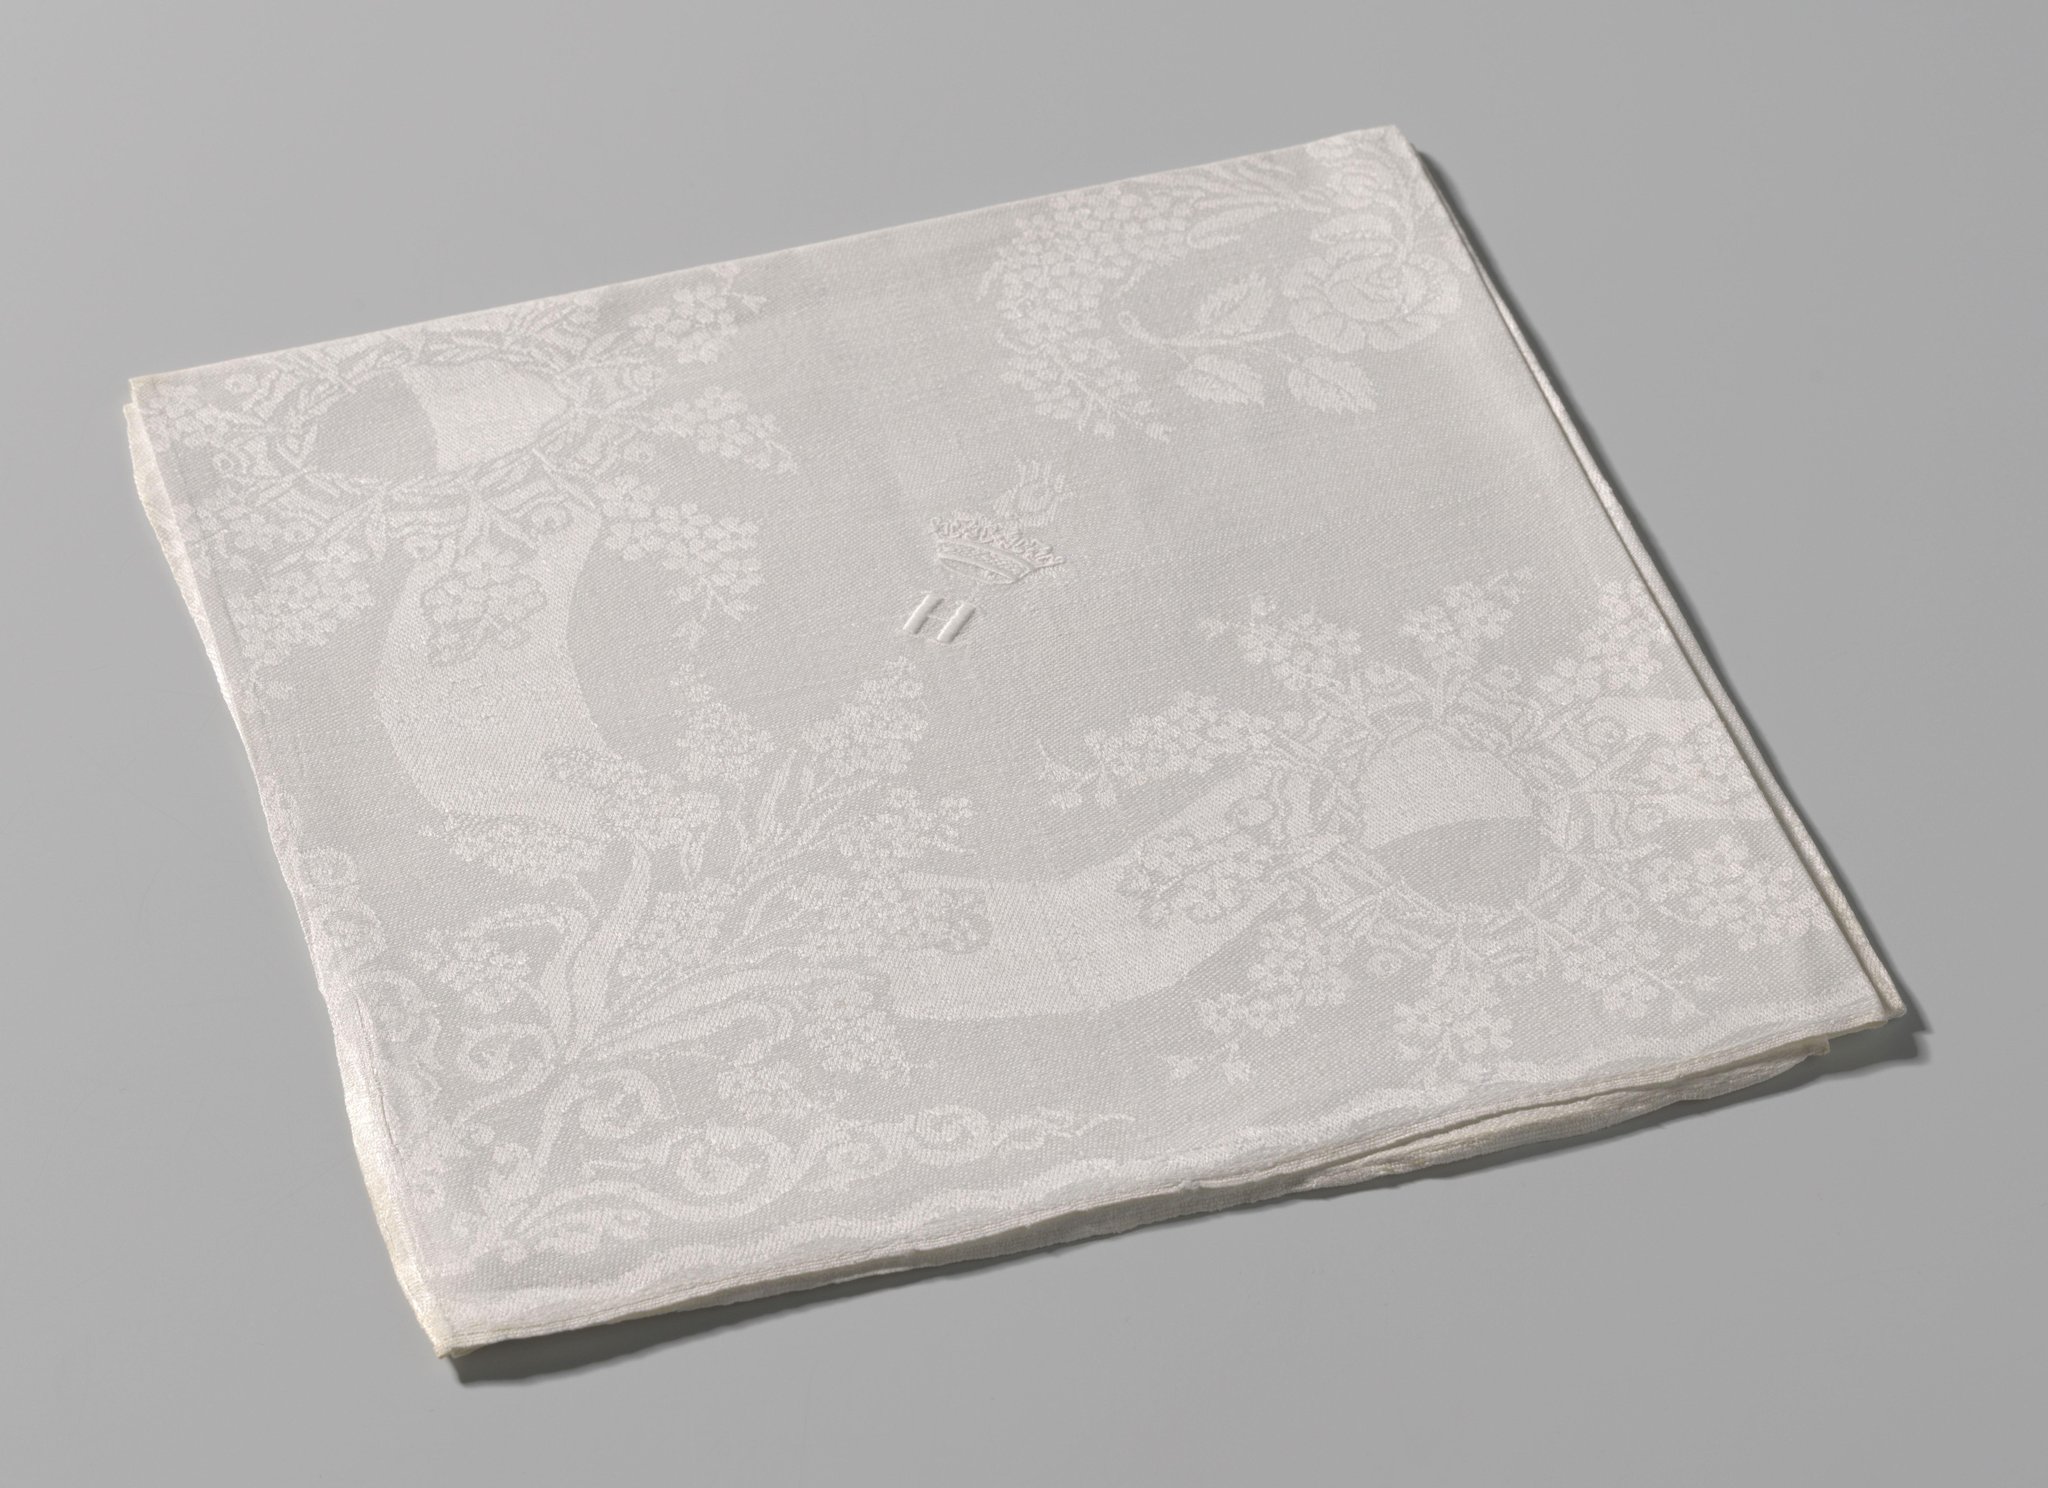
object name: napkin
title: Servet van wit linnendamast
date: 1859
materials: linen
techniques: damask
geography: borne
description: Wit linnen damasten servet met "rand met lint", merk kroon H.